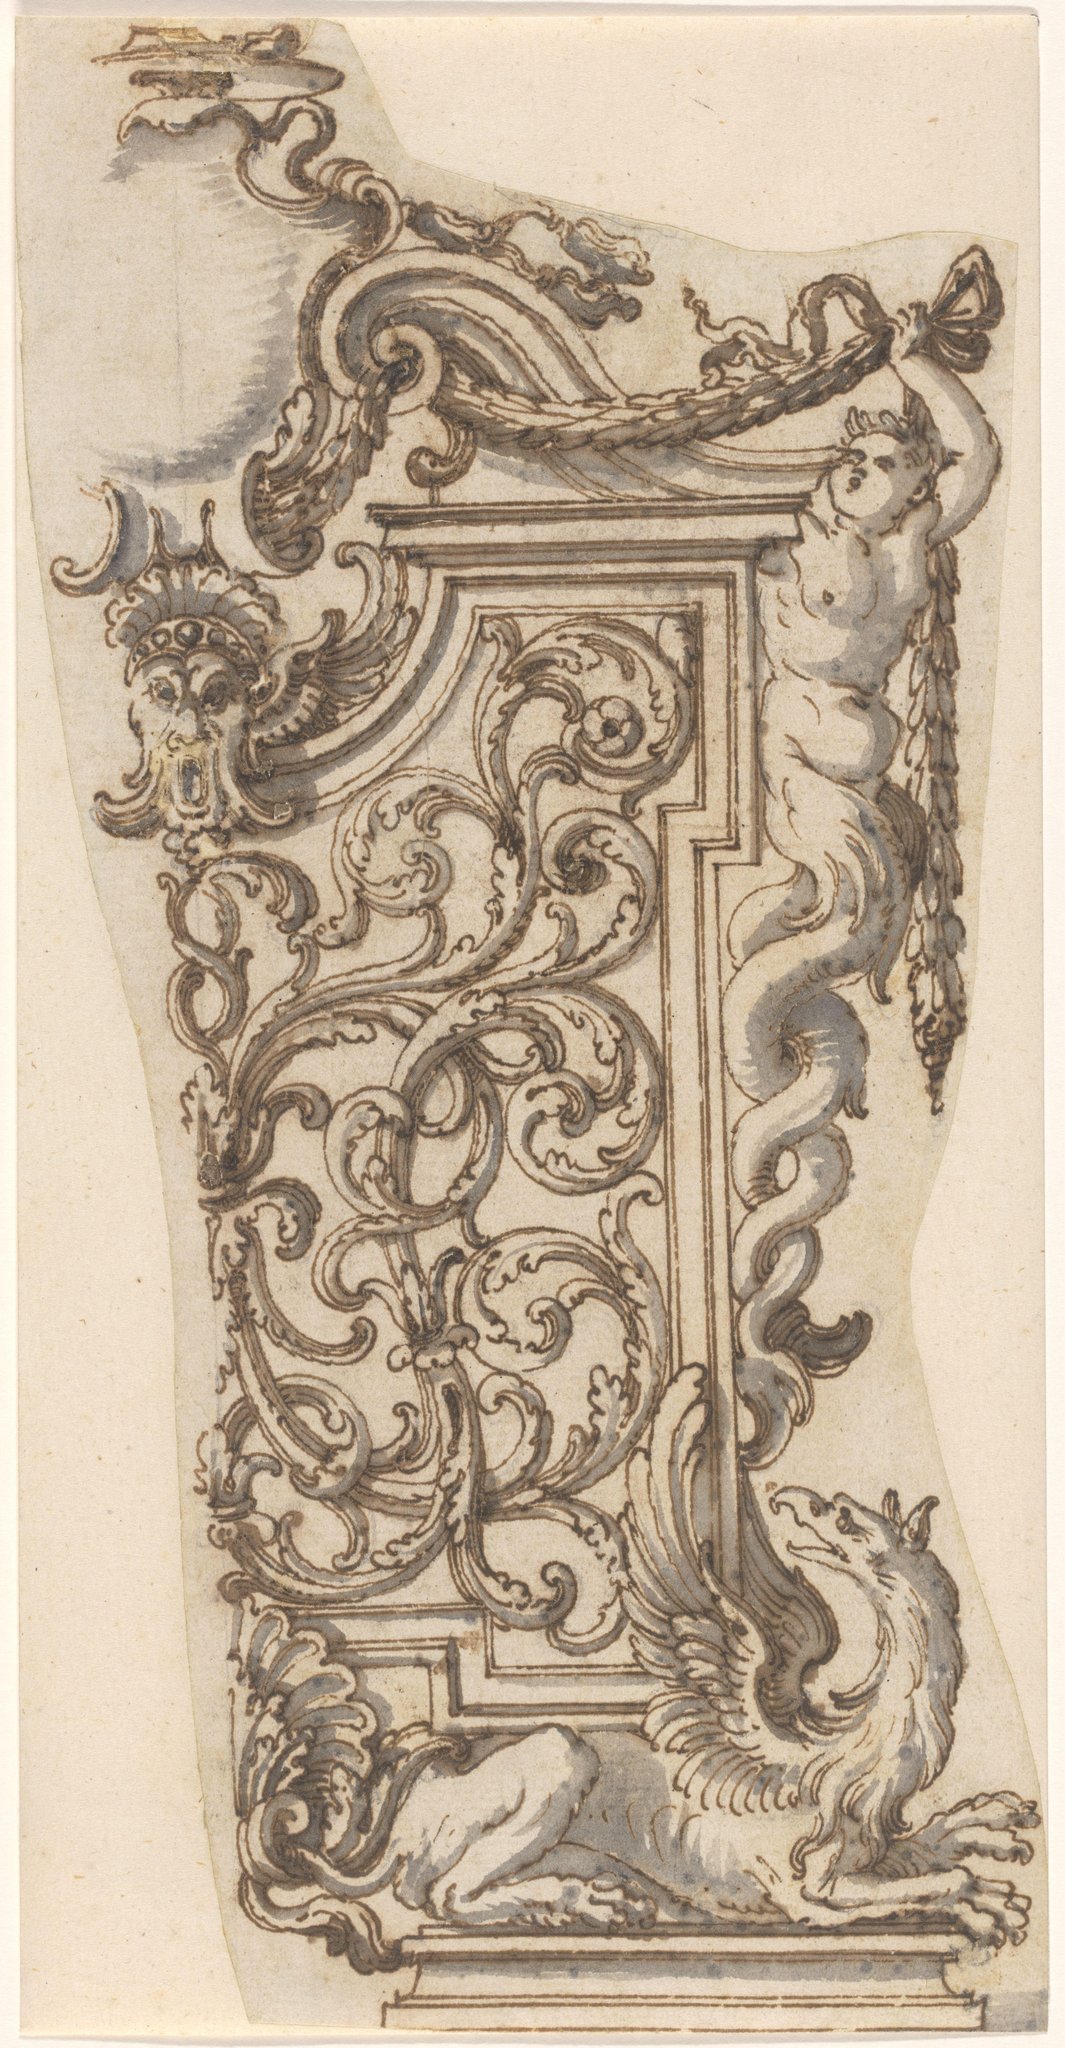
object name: design drawing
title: Ontwerp voor een kamerscherm (?)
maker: philipp schor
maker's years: 1646-1715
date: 1675-1690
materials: ink, paper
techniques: brush, pen, snipping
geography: rome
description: Een eerdere, meer schetsmatige versie van hetzelfde ontwerp bevindt zich in de Engelse koninklijke verzameling op Windsor Castle (Anthony Blunt en Hereward Lester Cooke, The Roman Drawings of the XVII & XVIII Centuries in the Collection of Her Majesty The Queen at Windsor Castle, Londen 1960, nr. 958 (inv. nr. 5579), als Giovanni Paolo Schor).